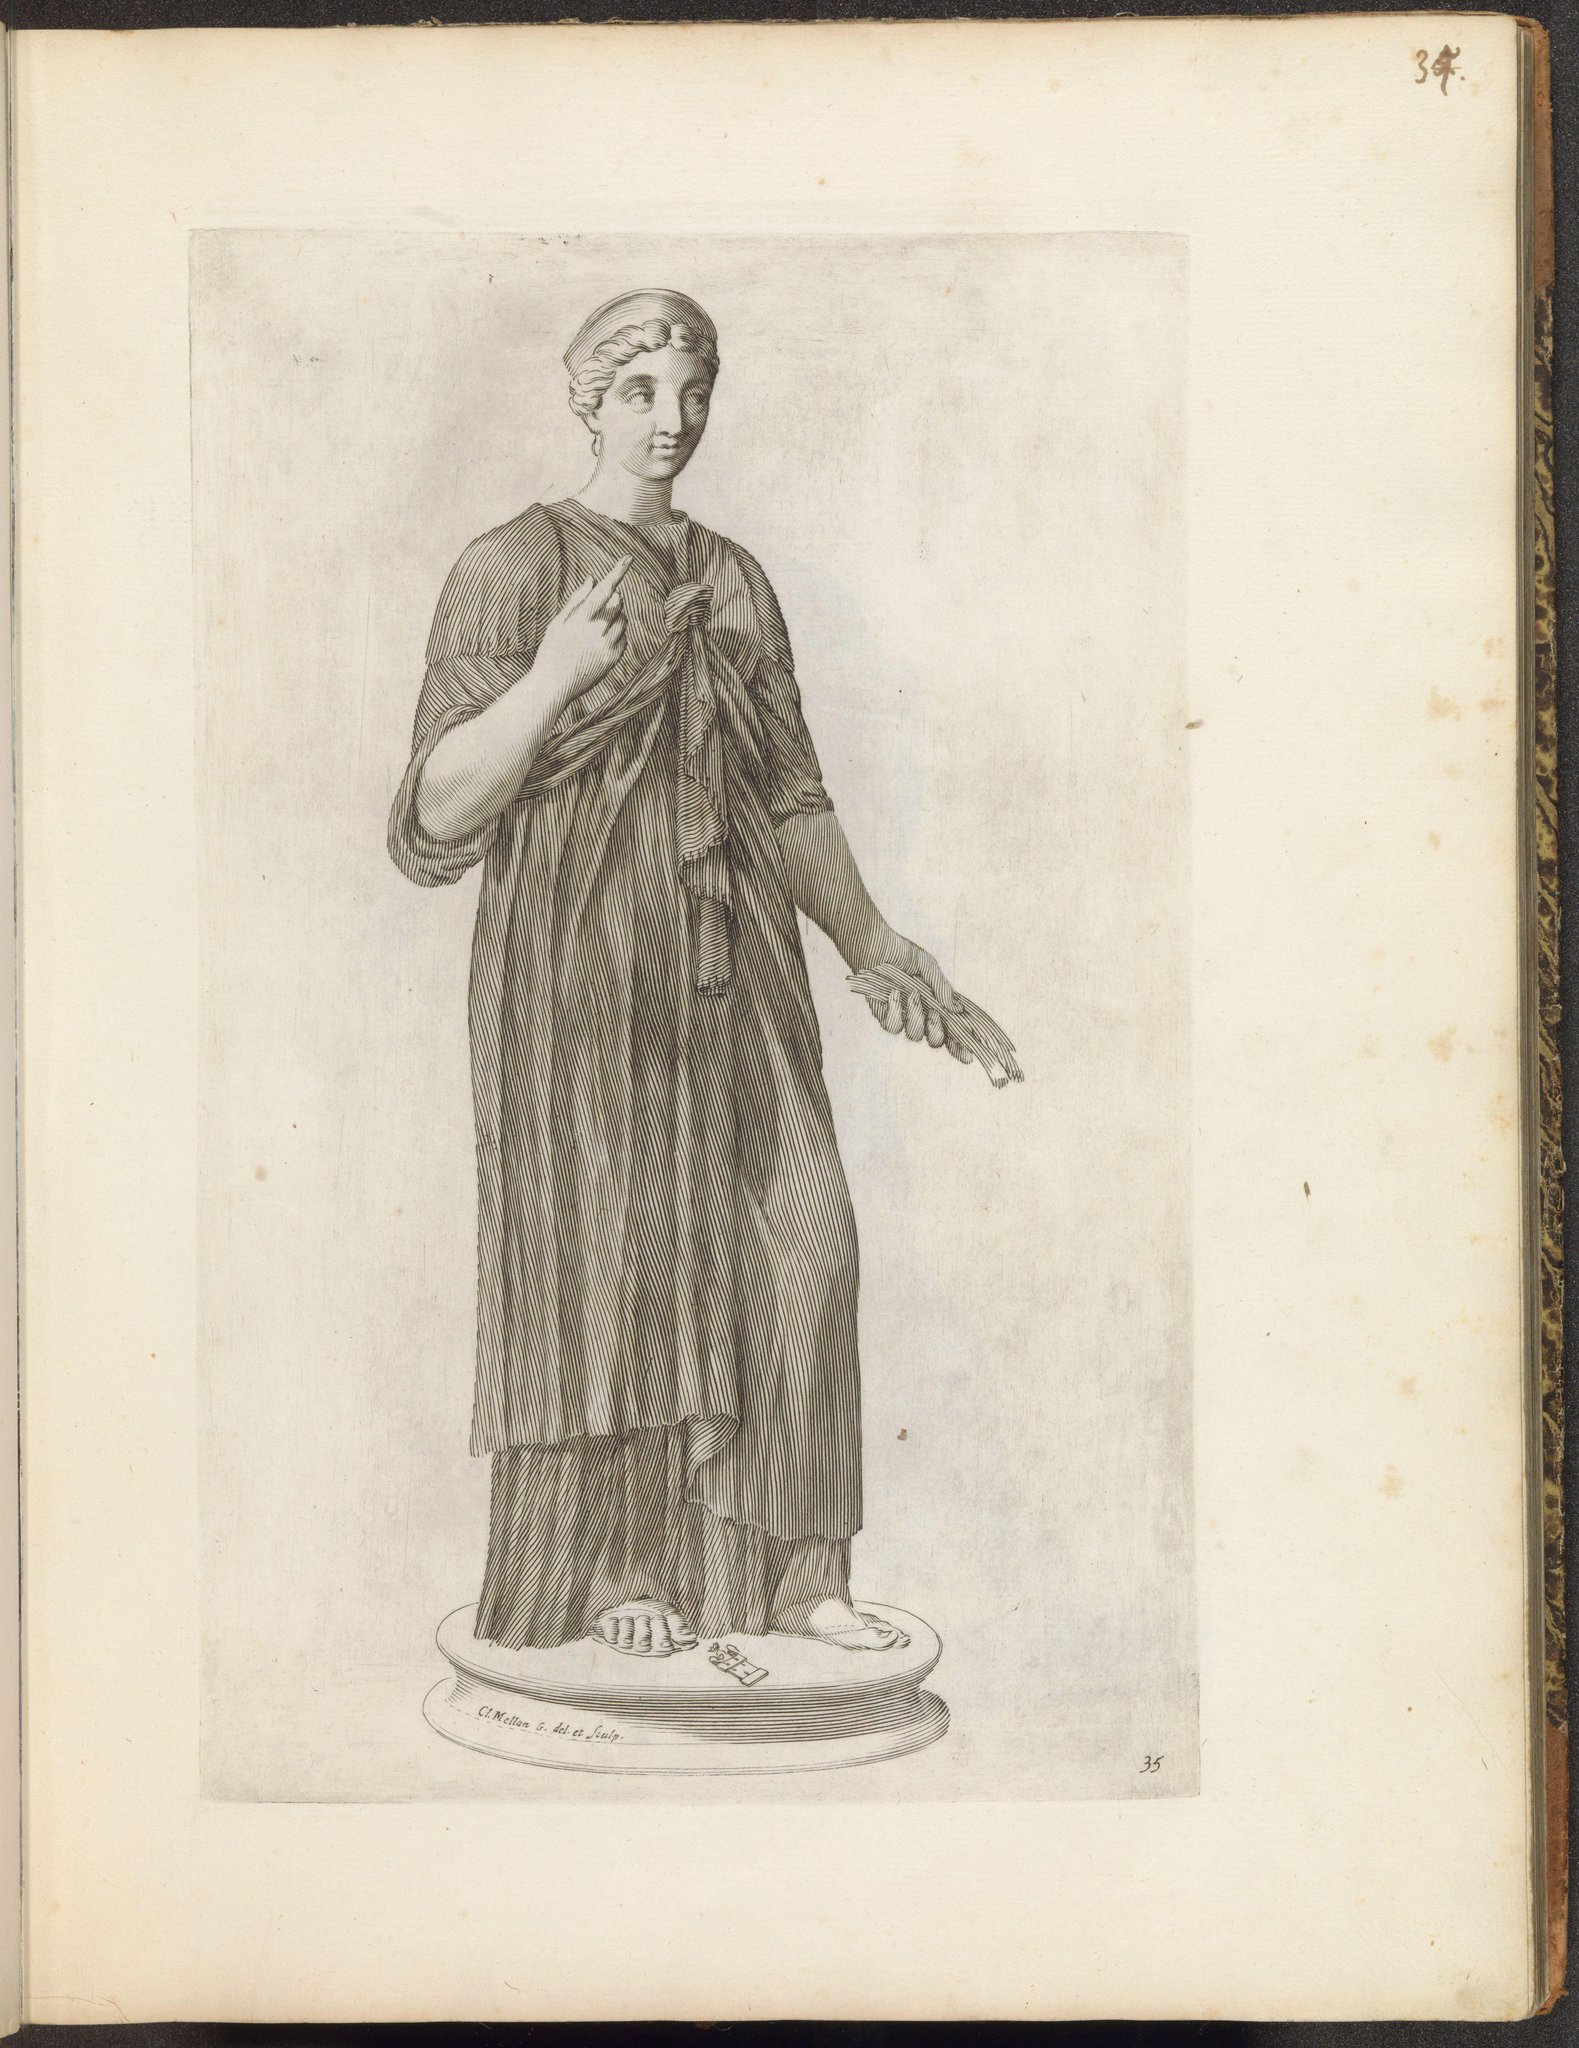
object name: print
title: Galleria Giustiniana del Marchese Vincenzo Giustiniani I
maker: claude mellan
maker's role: draughtsman, print maker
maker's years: 1598-1688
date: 1636-1647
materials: paper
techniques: engraving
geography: rome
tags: (story of) ceres (demeter), piece of sculpture, reproduction of a piece of sculpture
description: Standbeeld van een vrouw met (vermoedelijk) korenaren in haar linkerhand. Waarschijnlijk de godin Ceres. Op de basis het wapenschild van Vincenzo Giustiniani. Prent maakt deel uit van een album met een serie prenten naar de sculpturen in de verzameling in de Galleria Giustiniani te Rome.